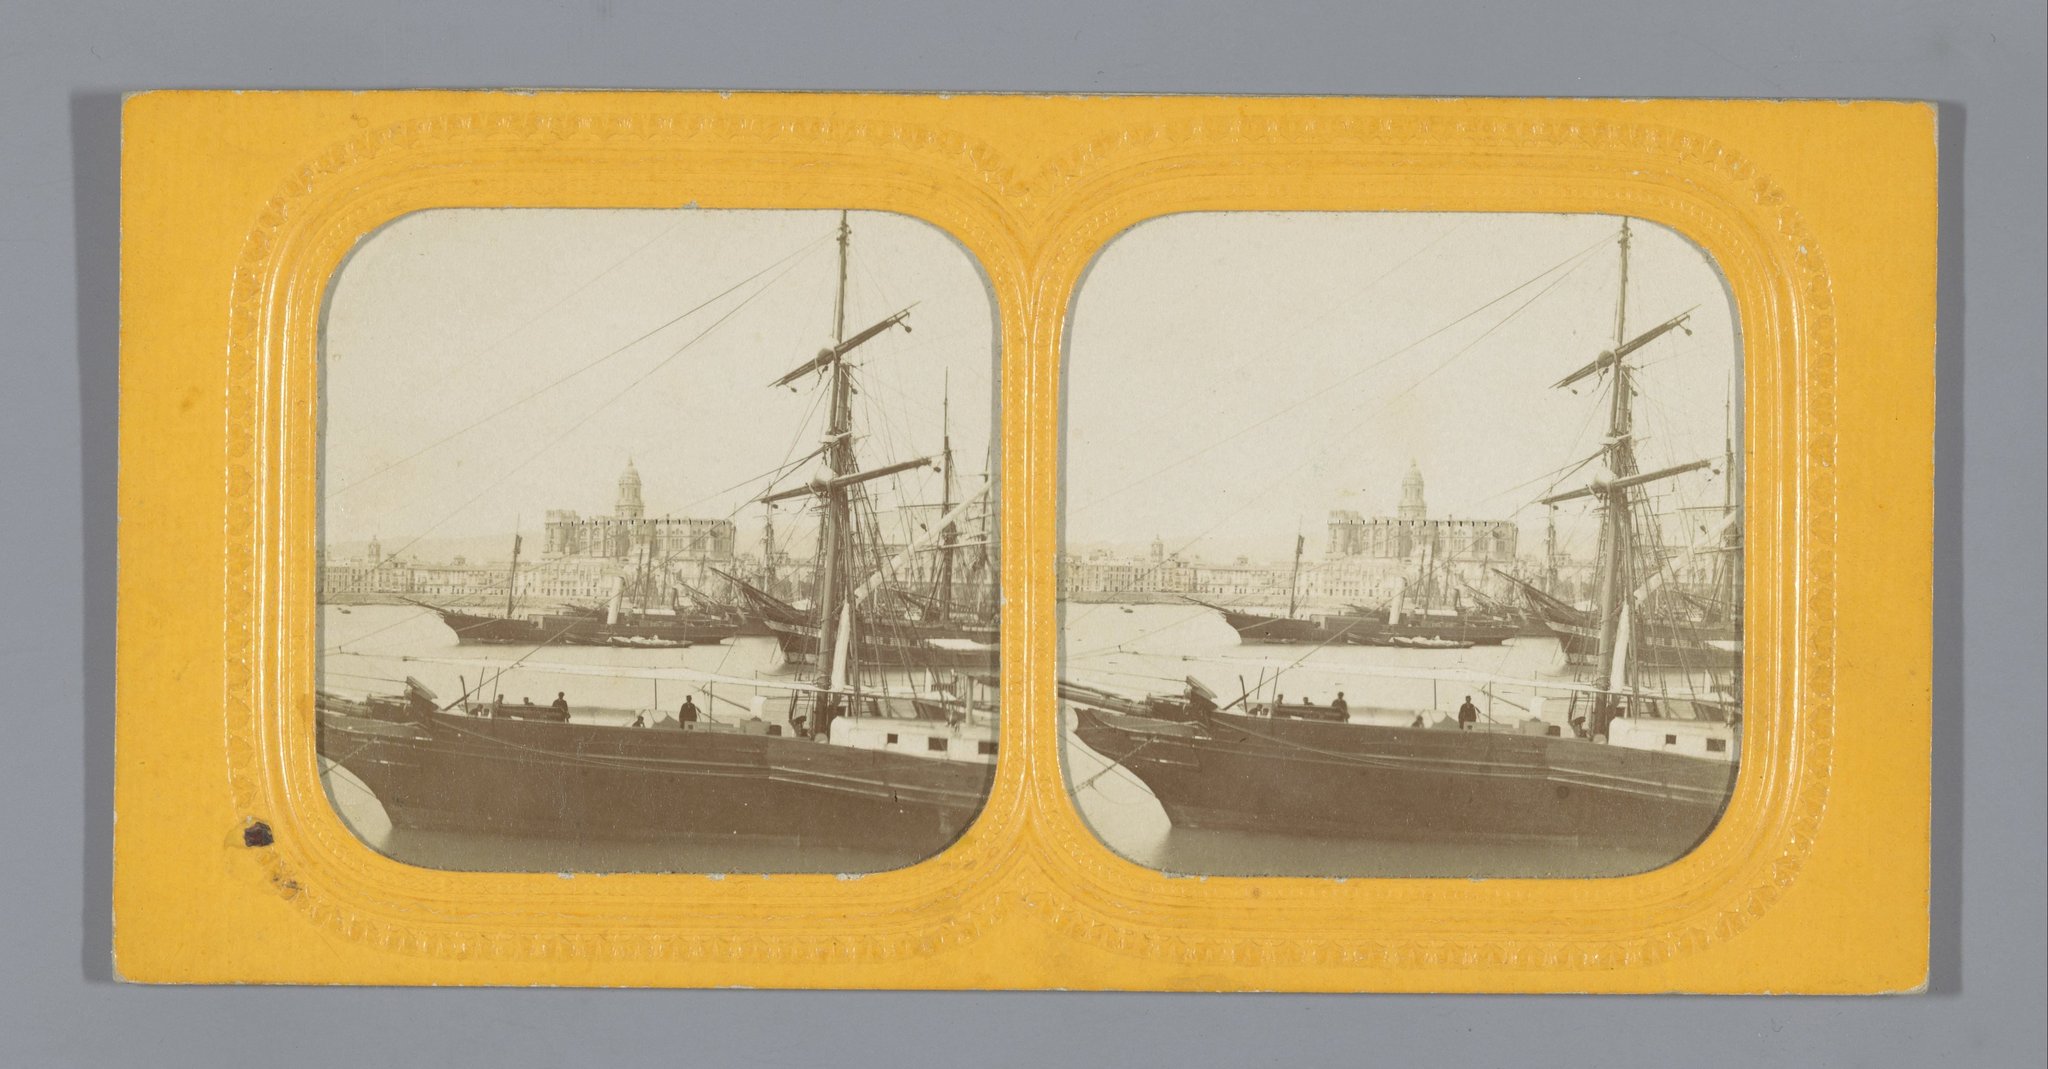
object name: tissue stereograph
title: Rue et port a Malaga, Espagne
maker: Anonymous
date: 1855-1875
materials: cardboard, paper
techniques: albumen print, hand coloring, perforating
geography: málaga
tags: harbour, ships (in general) - cc - more than one ship